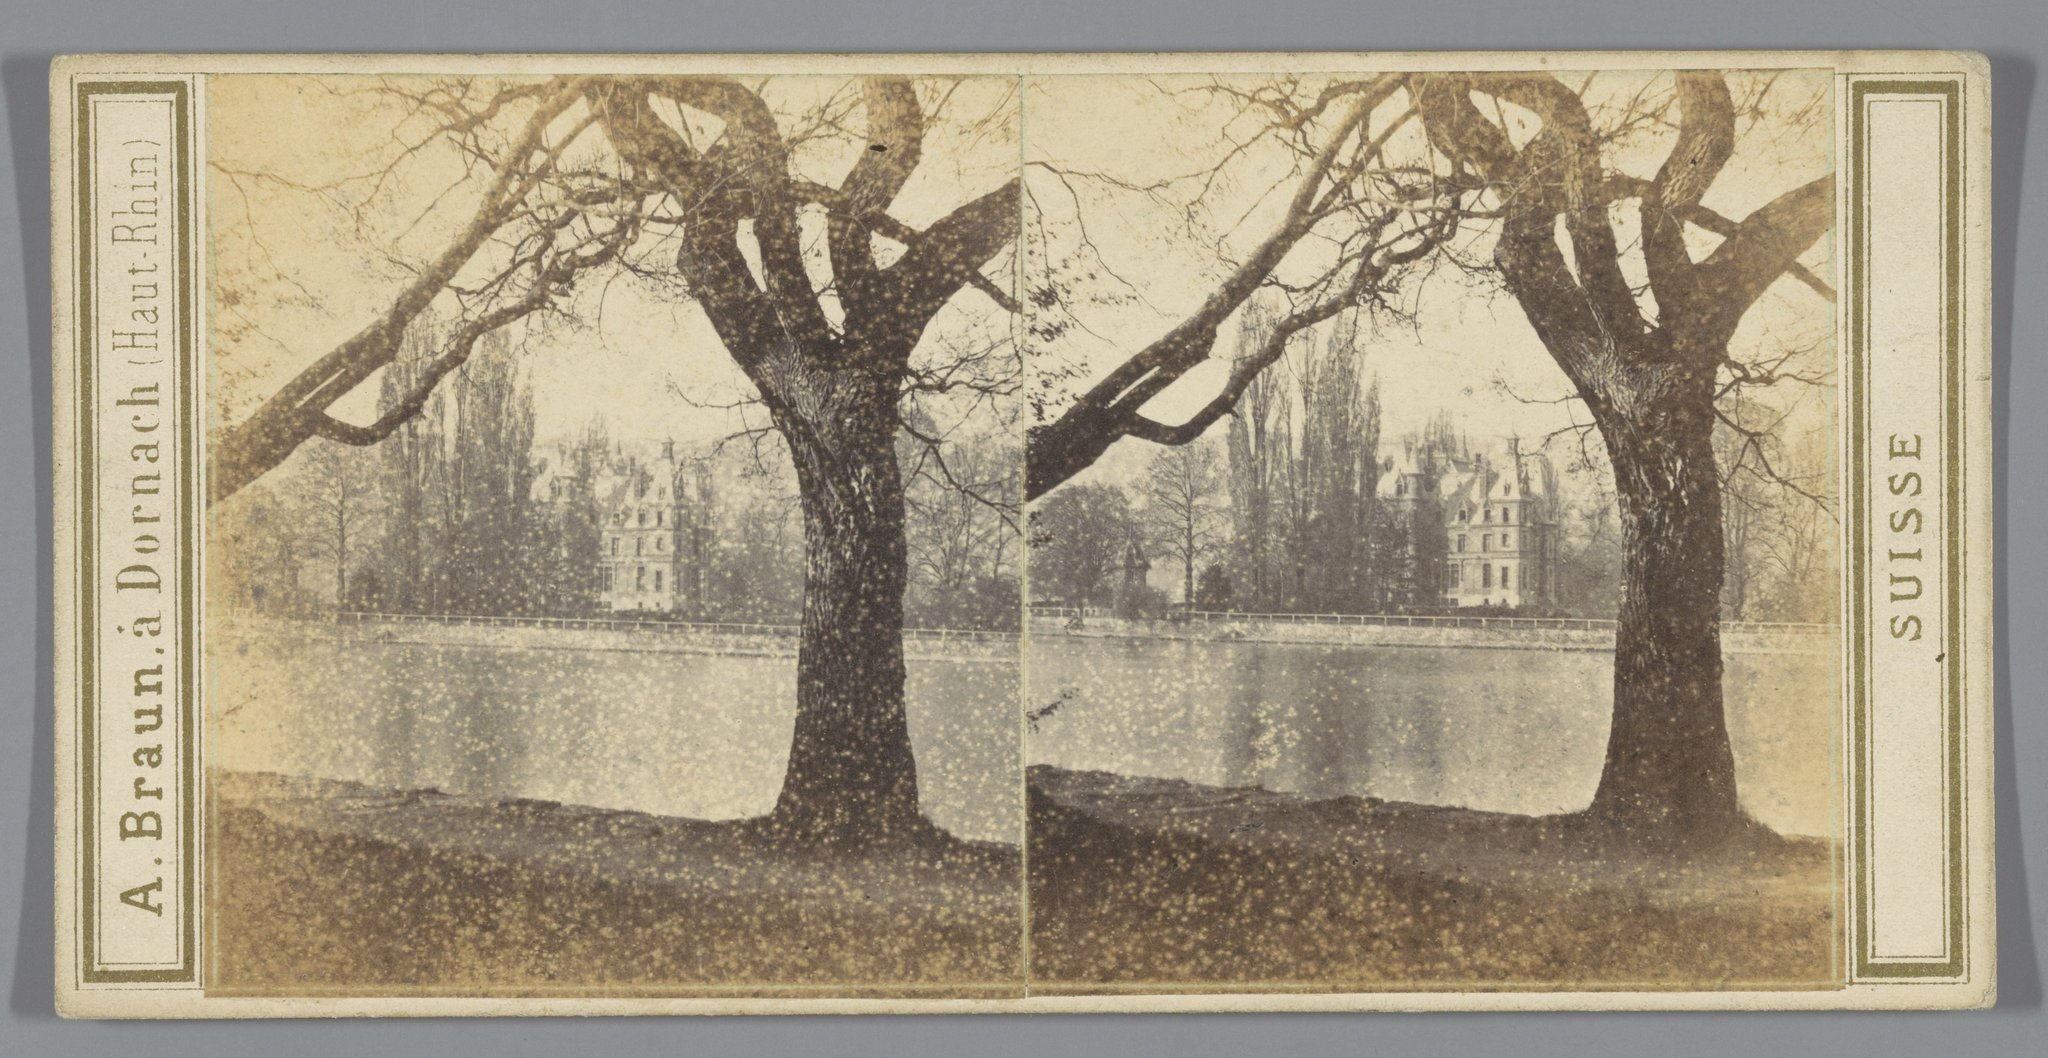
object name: stereograph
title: Suisse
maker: Anonymous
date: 1860-1866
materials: cardboard, paper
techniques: albumen print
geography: dornach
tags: schadau castle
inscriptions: number: ‘No 3726.’